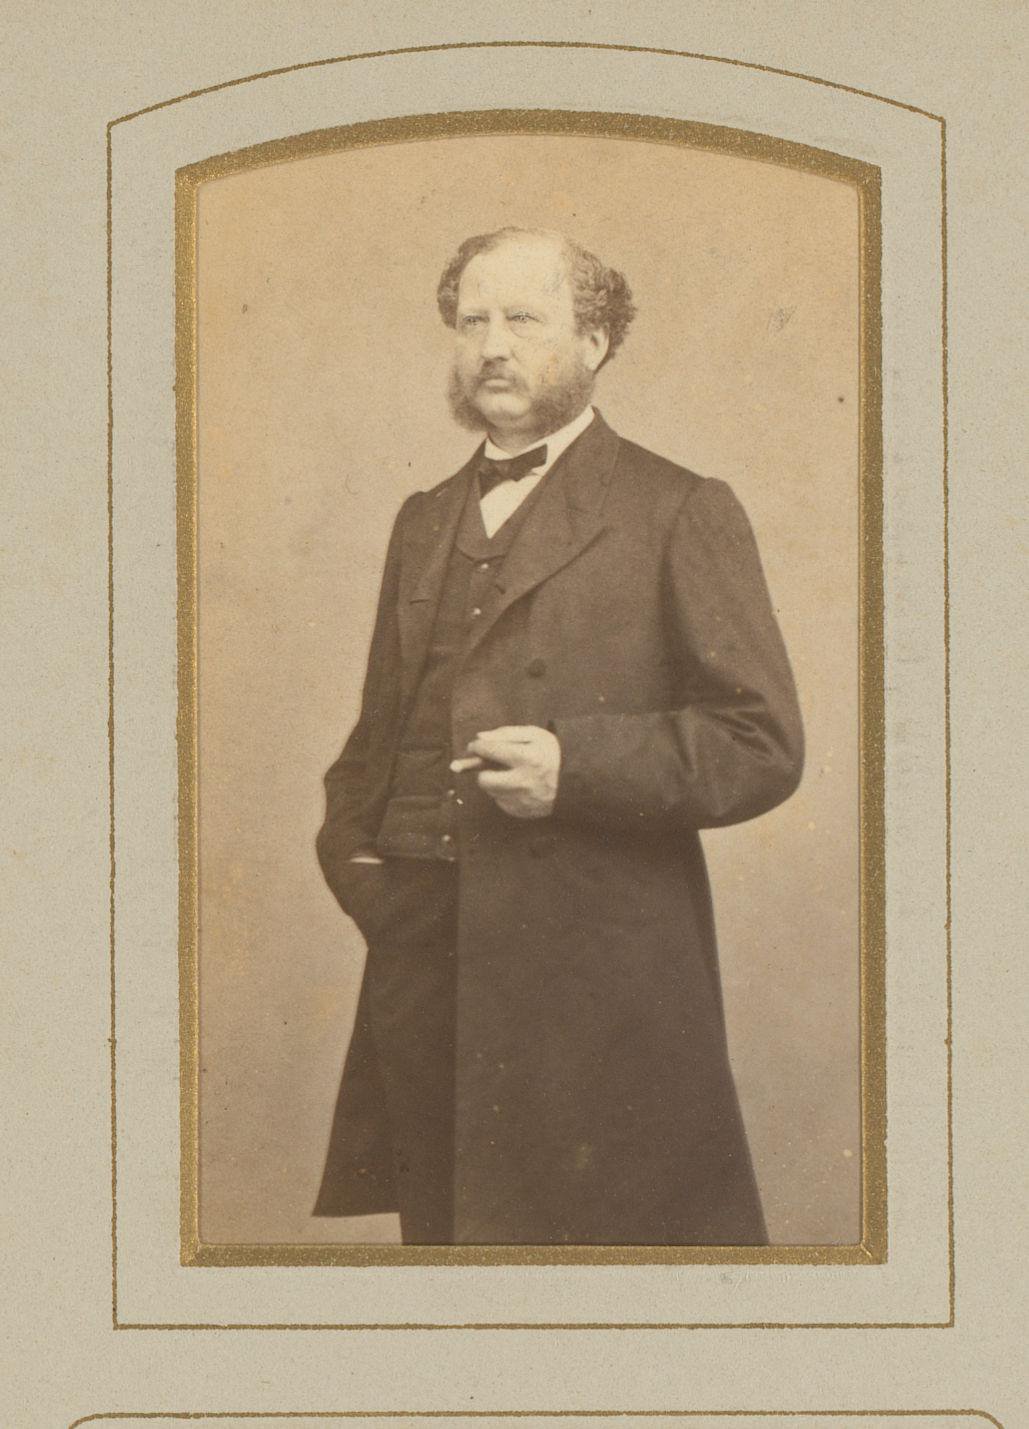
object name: carte de visite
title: Portret van een staande man met sigaar in de hand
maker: pierre chargois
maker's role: fotograaf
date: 1860-1880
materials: cardboard, photographic support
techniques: albumen print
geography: brussels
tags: standing figure, cigar, historical persons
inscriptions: inscription: ‘PIERRE CHARGOIS/ 26, rue de l'Ecuyer;/ BRUXELLES.’